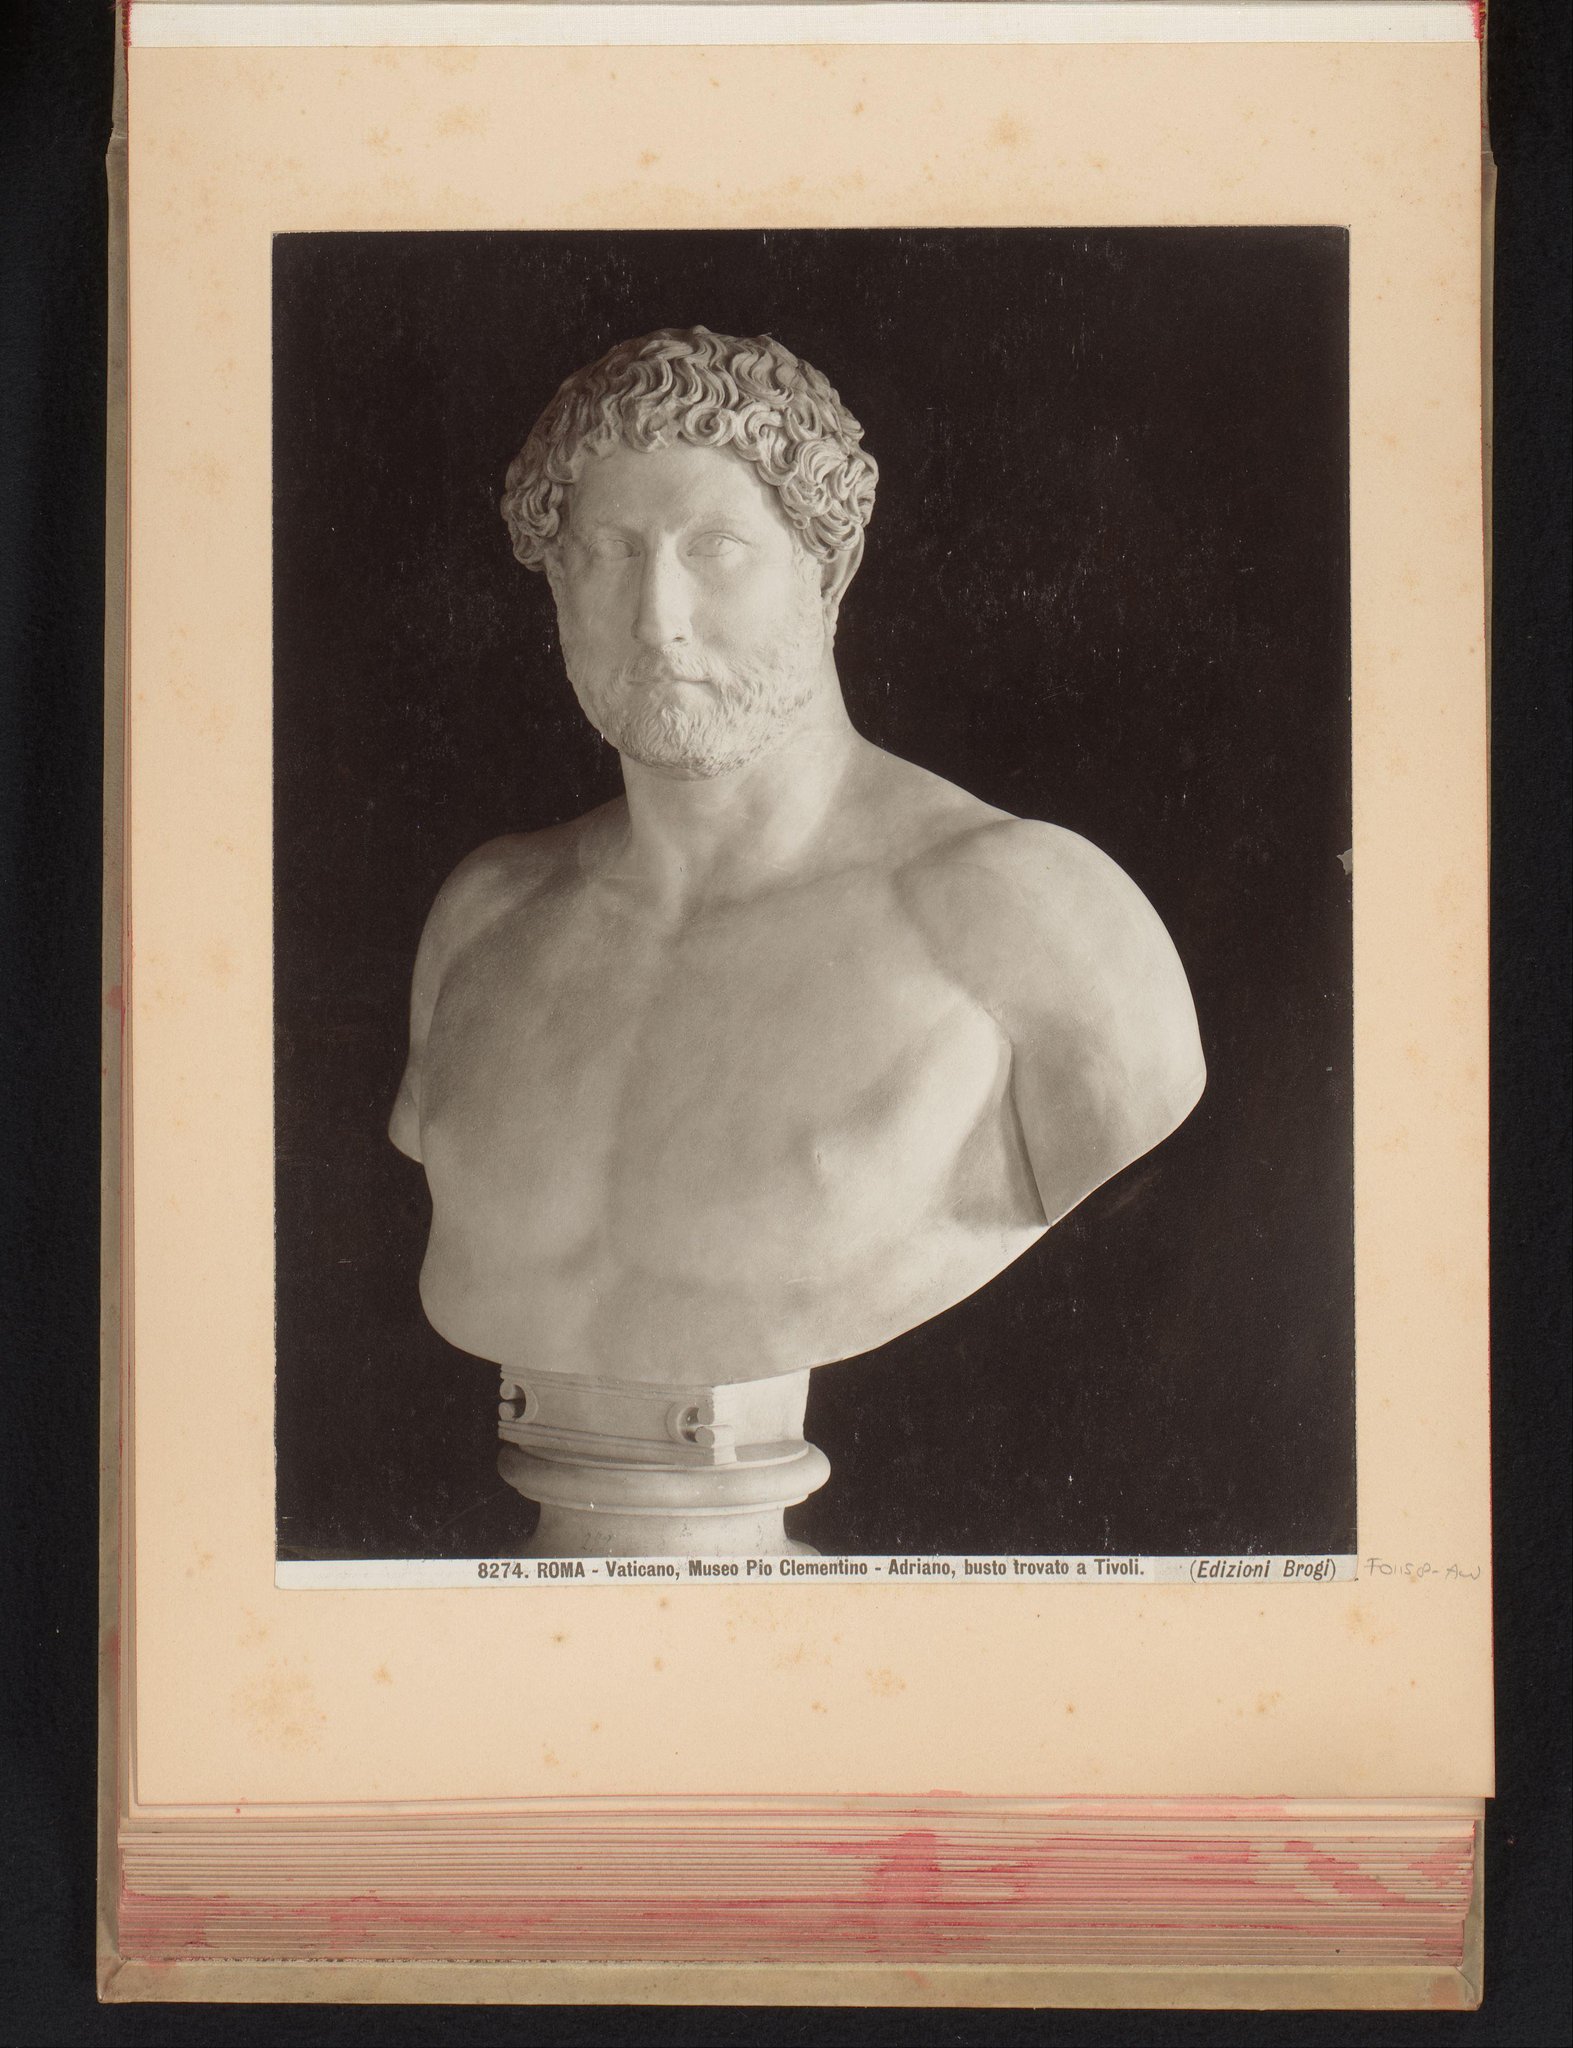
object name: photograph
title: Buste van keizer Hadrianus in de Vaticaanse Musea te Vaticaanstad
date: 1875-1907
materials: photographic support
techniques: gelatin silver print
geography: vatican museums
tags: ruler, sovereign, sculpture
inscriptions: number: ‘8274’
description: Onderdeel van Fotoalbum met opnames van bezienswaardigheden en kunstwerken in Italië.